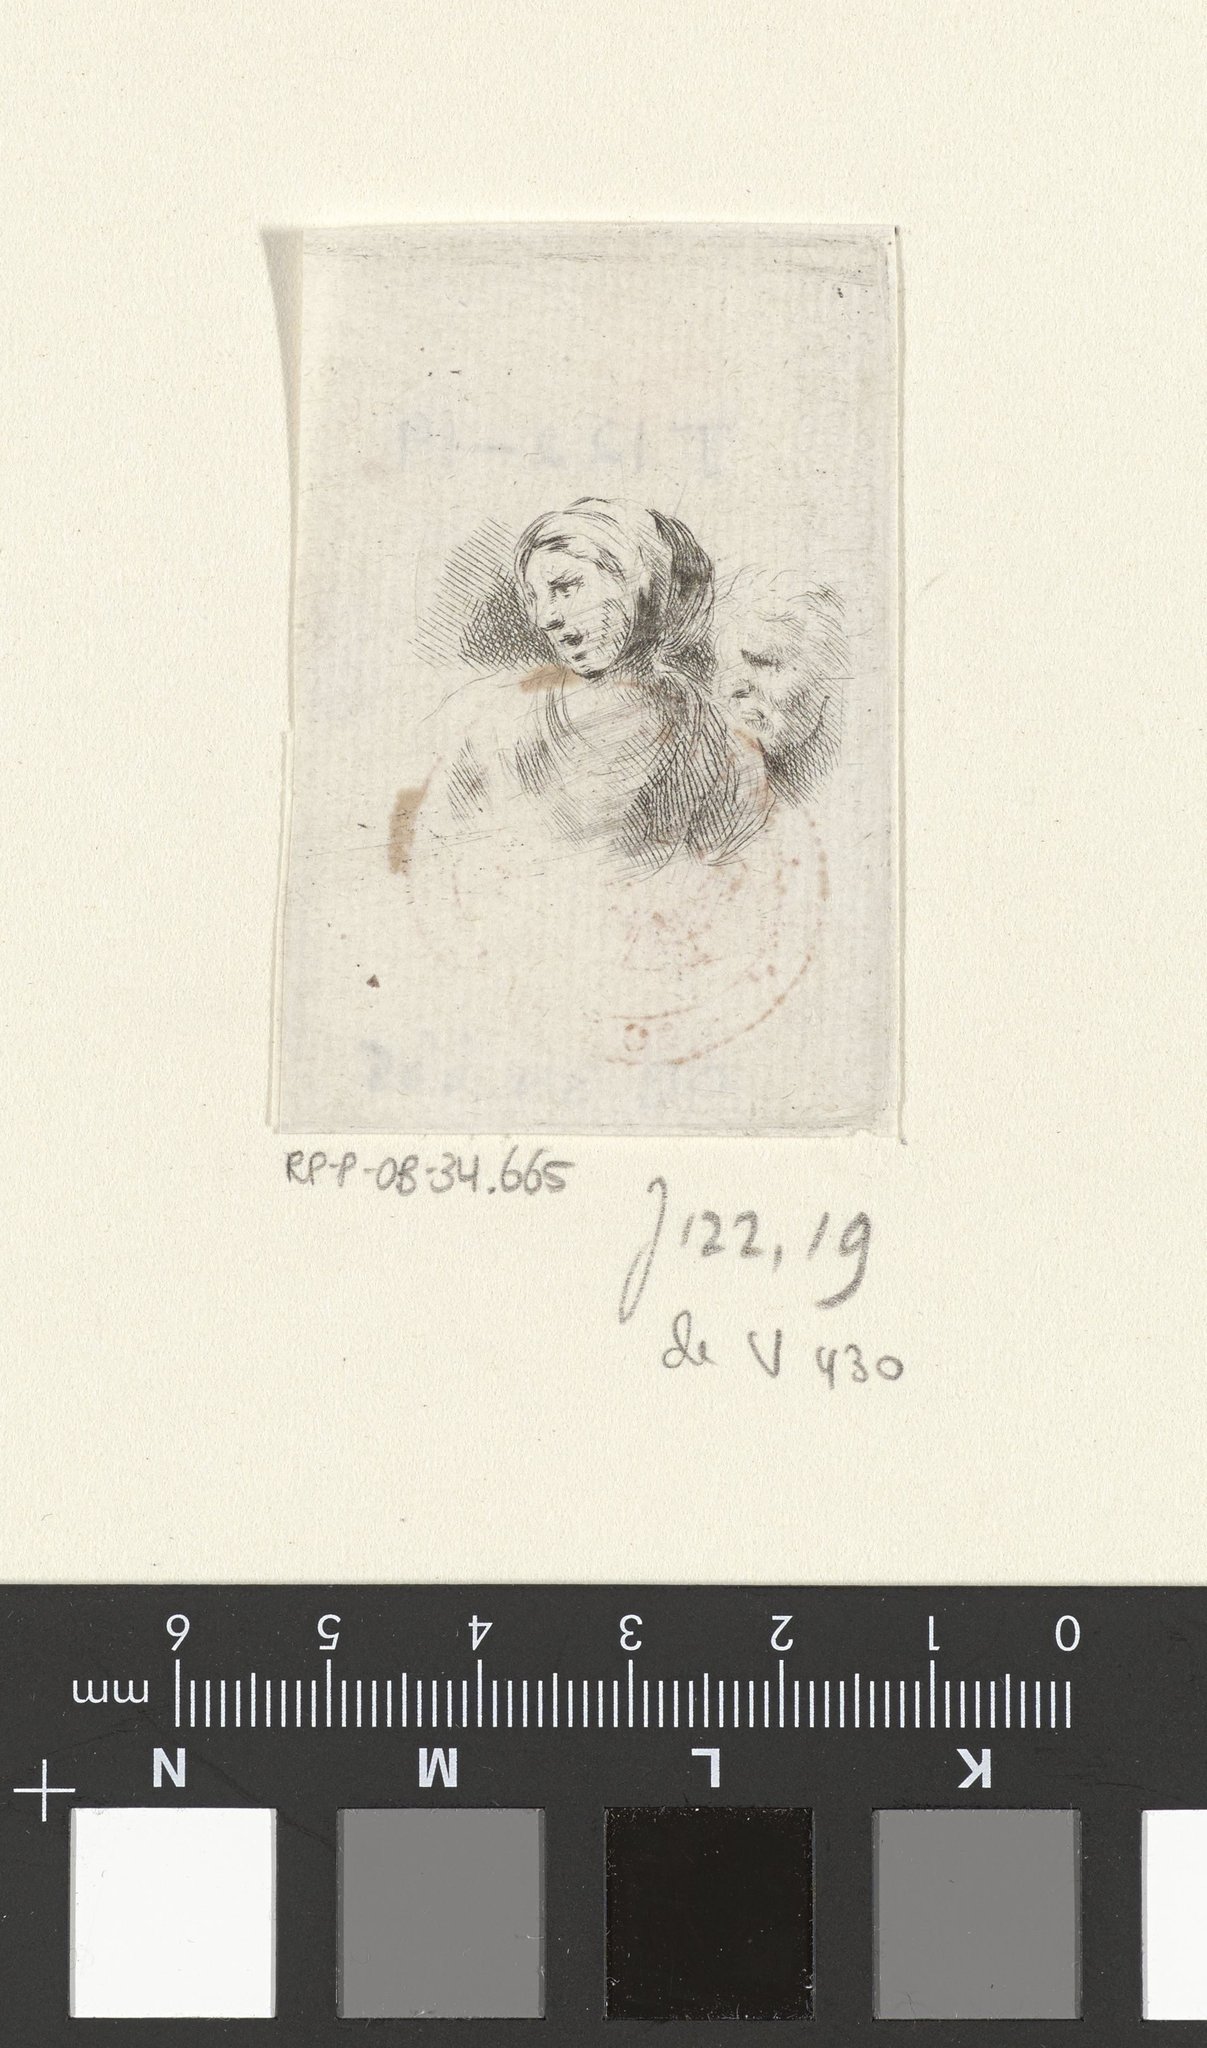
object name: print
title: Verzameling van verschillende krabbels en etsen [deel 2]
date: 1620-1664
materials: paper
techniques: etching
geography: france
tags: head (human), adult woman, head (human) (+ sideview, profile)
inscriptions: collector's mark: Lugt 240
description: Rechterhelft van een prent. Zie RP-P-OB-34.713 voor de linkerhelft. Prent uit een reeks van 47 prenten.